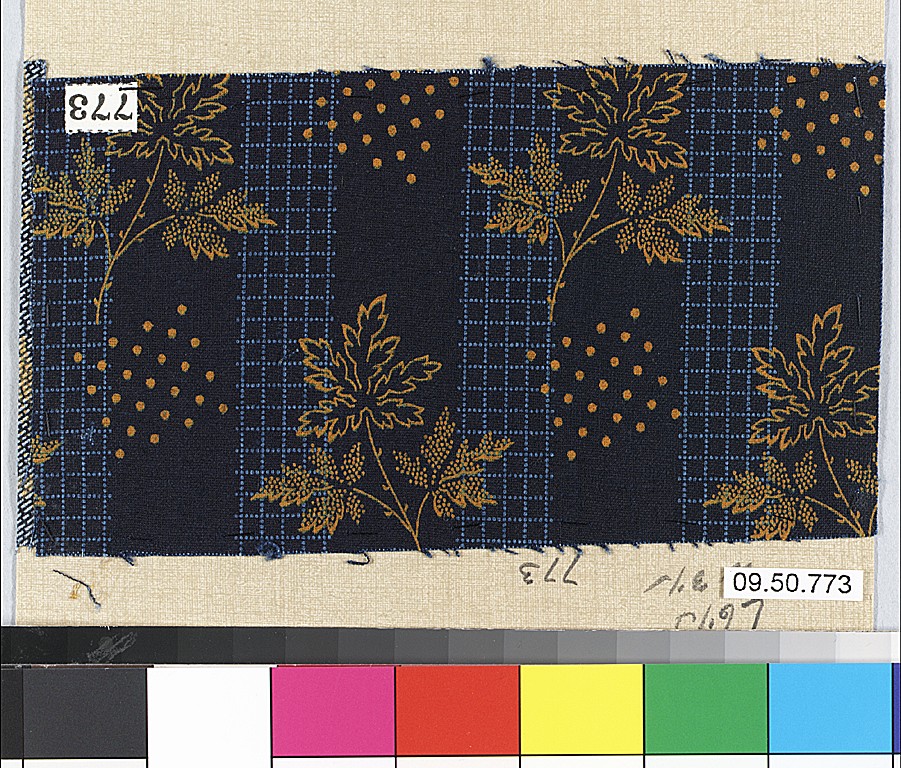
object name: piece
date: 1801-1900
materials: cotton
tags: leaves